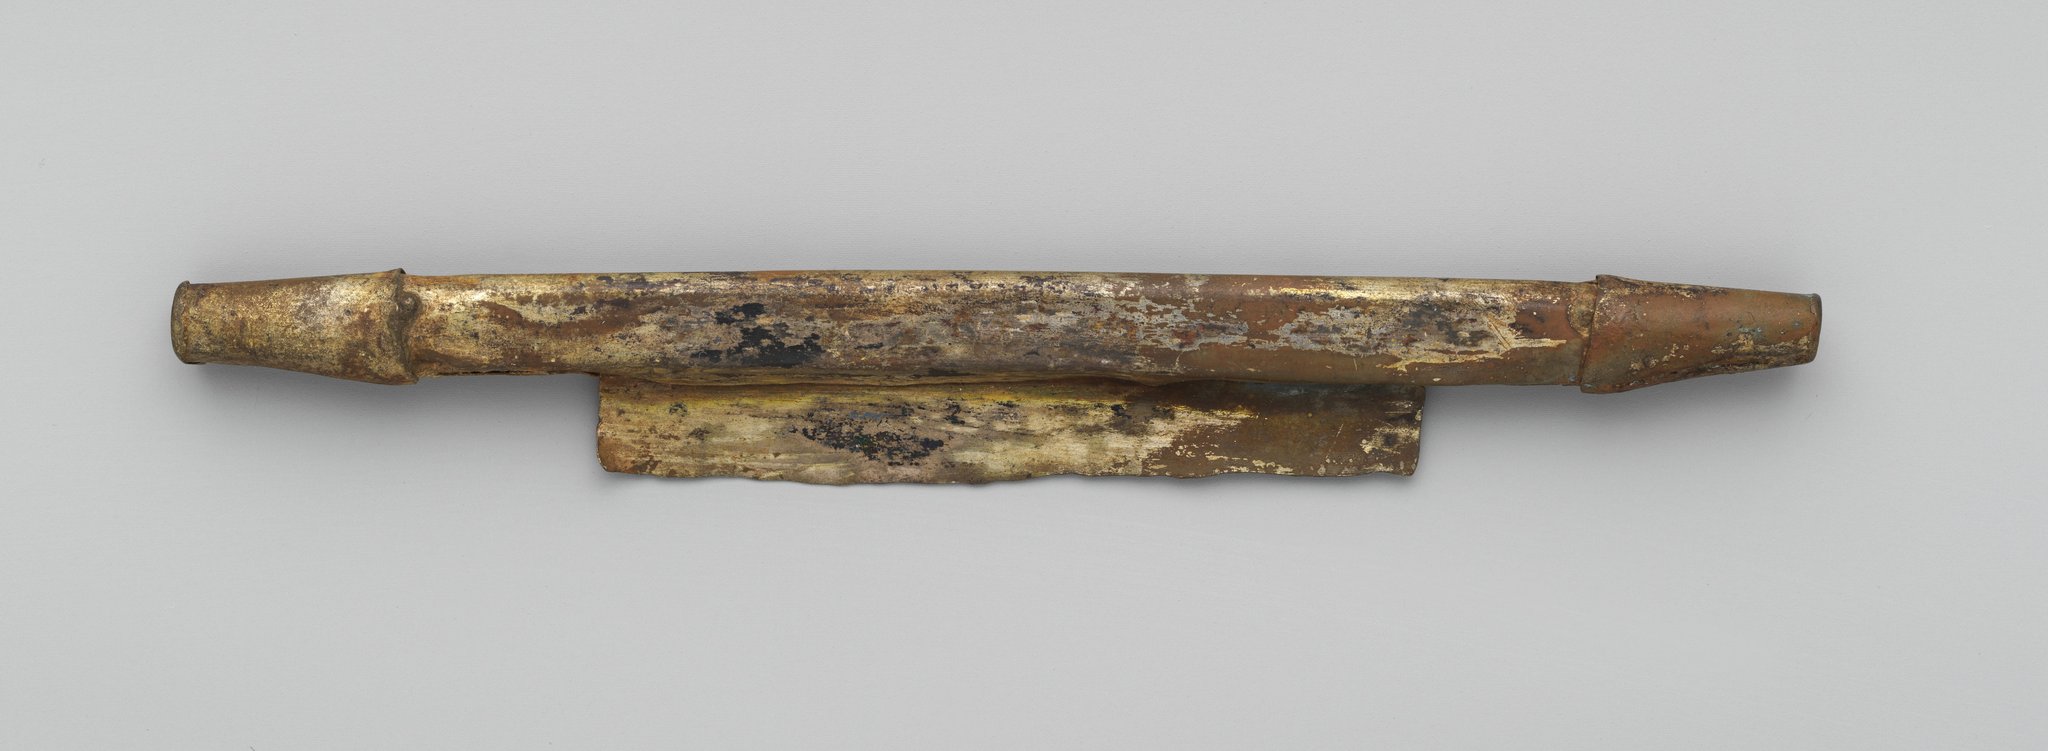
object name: litter bed part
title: Miniature Litter Section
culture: chancay or chimú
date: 1001-1500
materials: gilt, silver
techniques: hammering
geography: peru